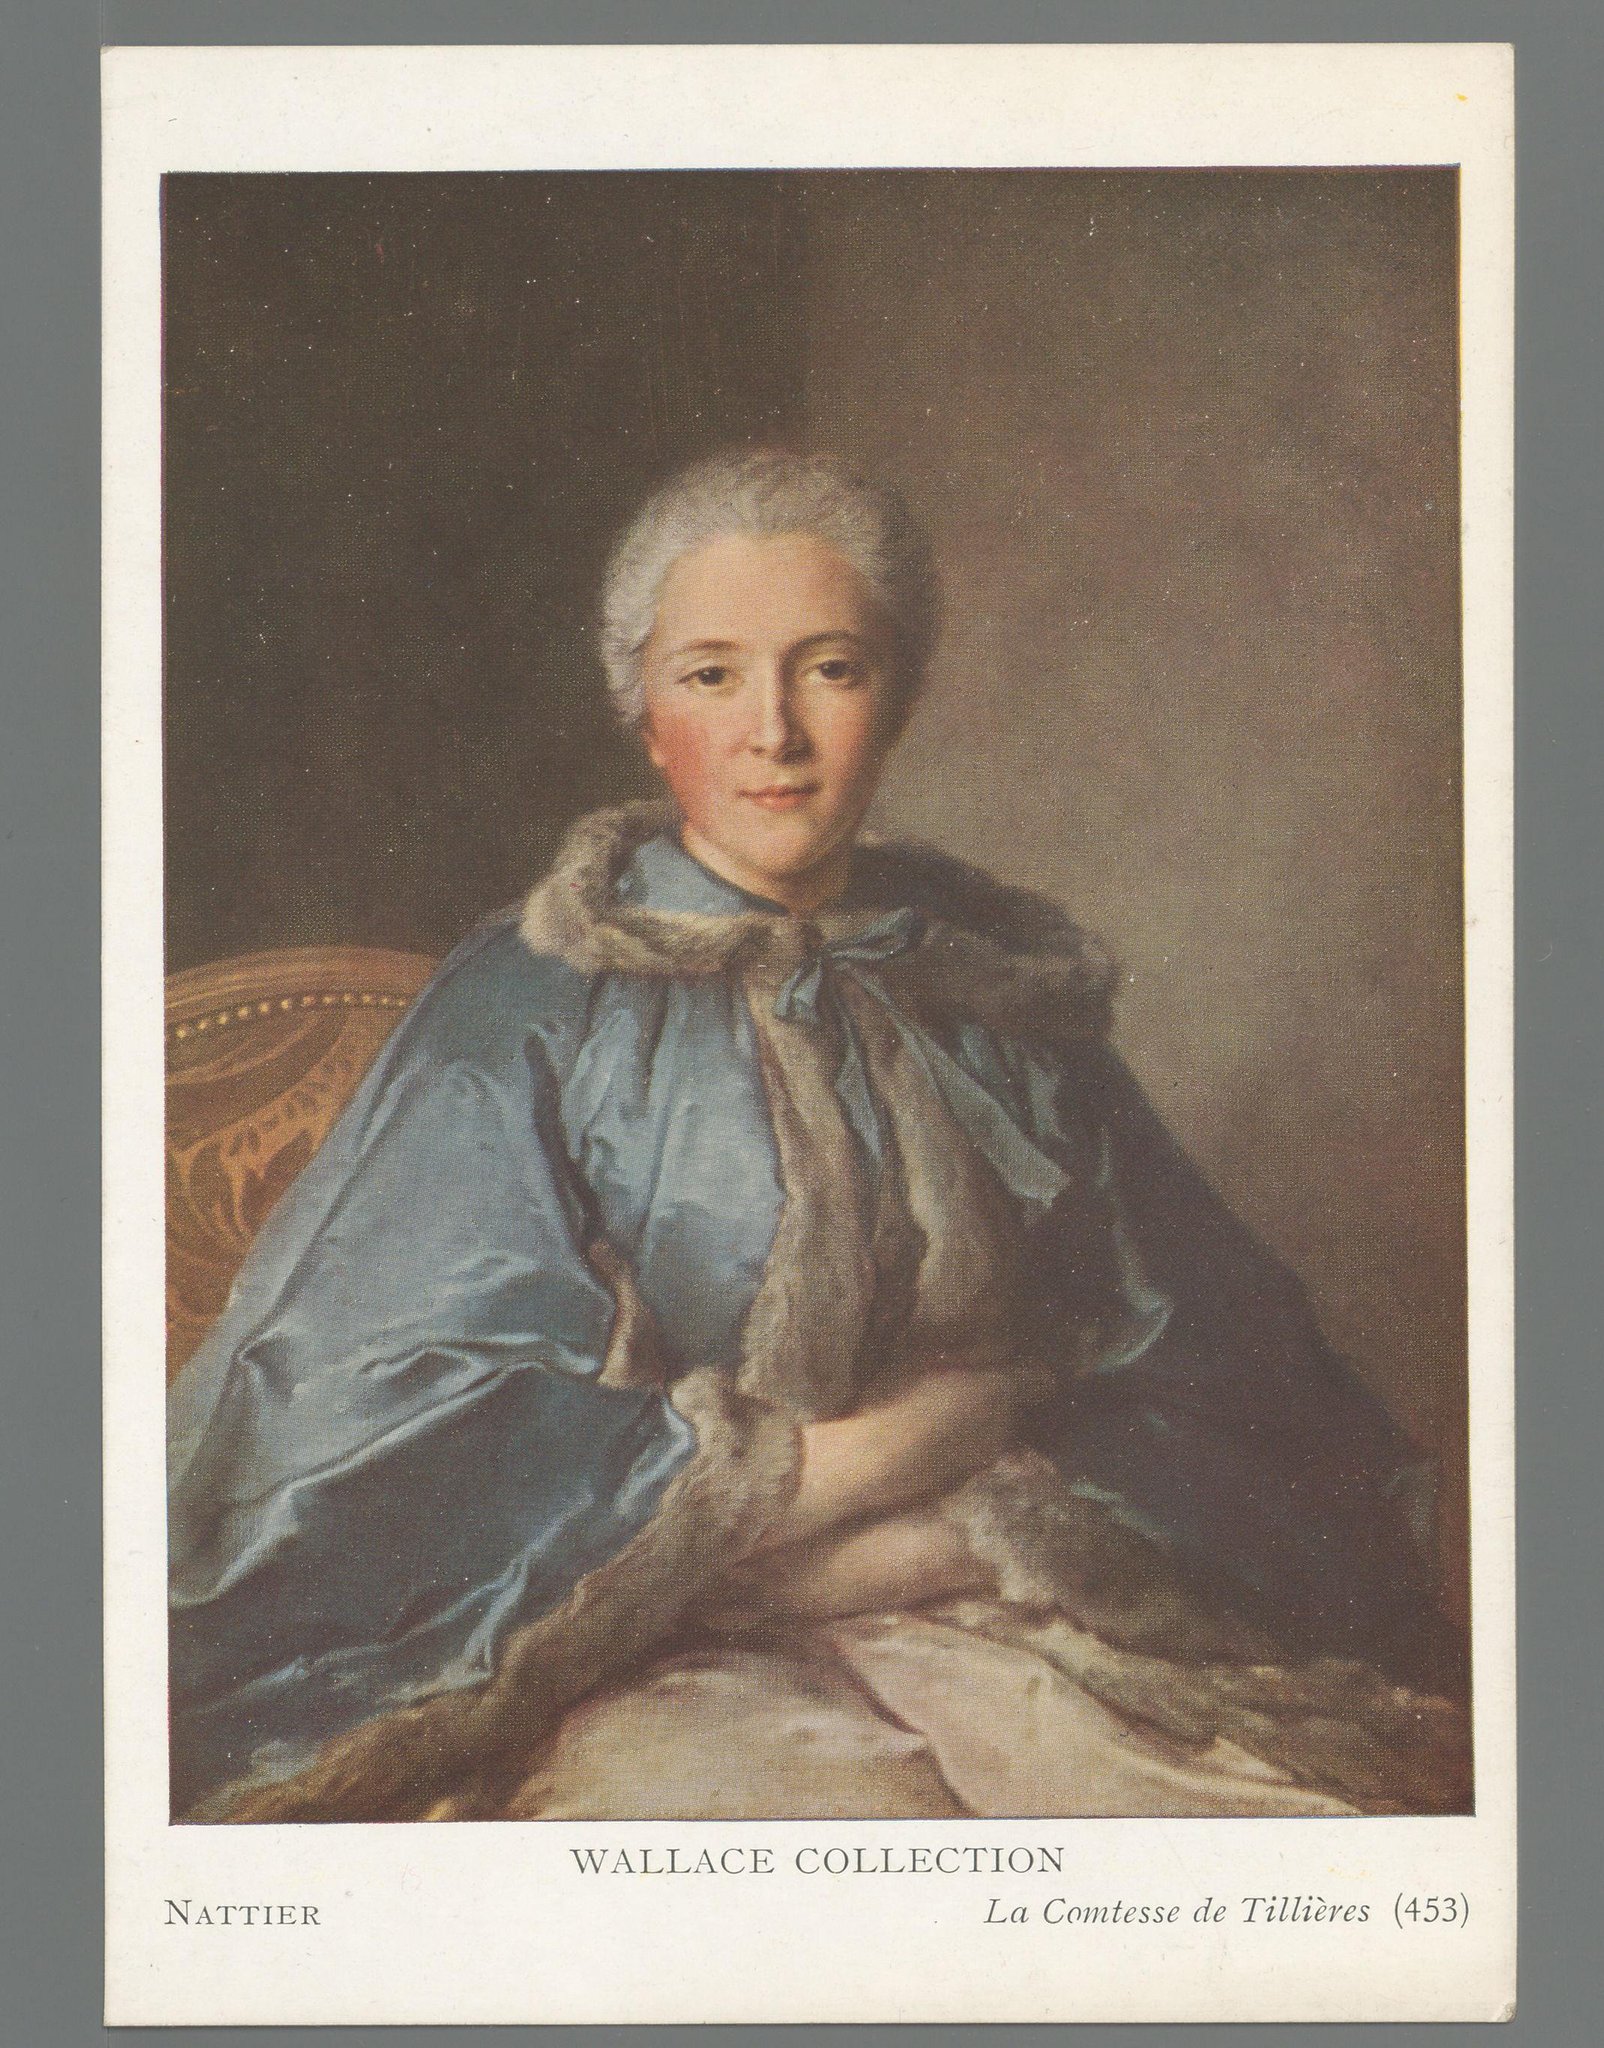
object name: ansichtkaart, prentbriefkaart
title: Wallace Collection. Nattier. La comtesse de Tillières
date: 1902-1950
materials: cardboard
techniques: color autotype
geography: london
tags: permanent exhibition, museum, picture, painting